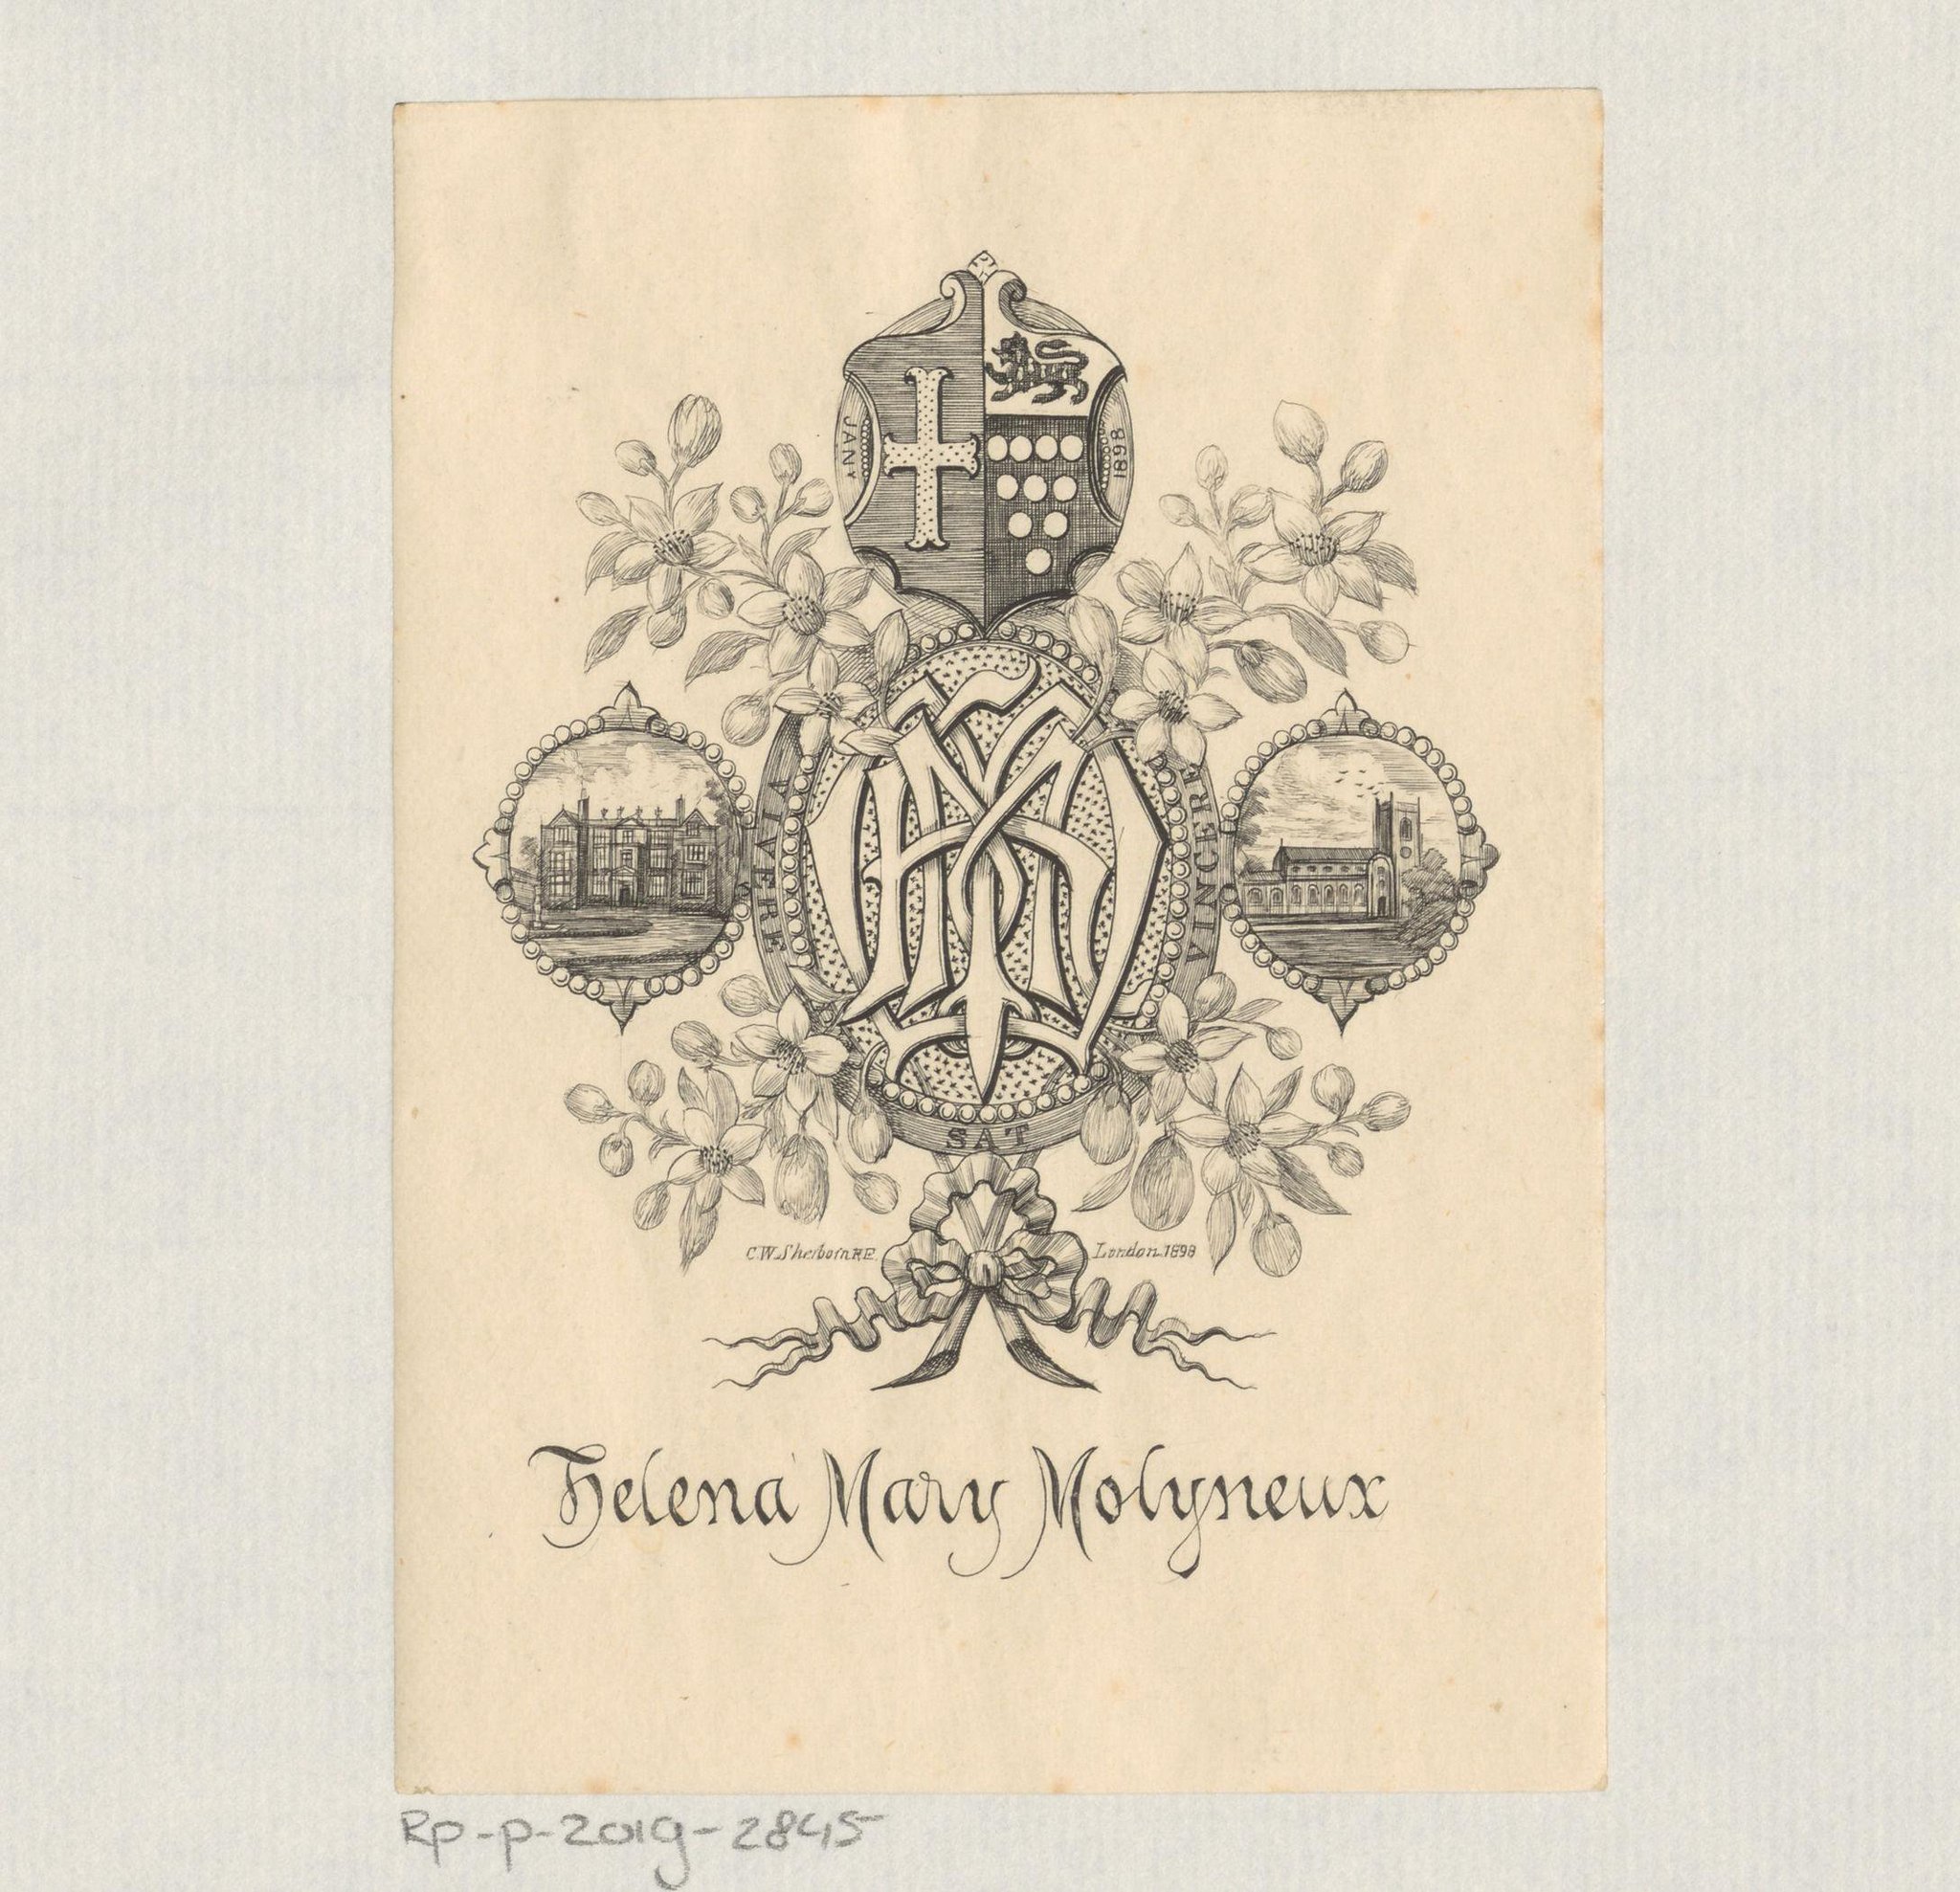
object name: bookplate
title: Ex libris van Helena Mary Molyneux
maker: charles william sherborn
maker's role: print maker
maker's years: 1831-1912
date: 1898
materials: paper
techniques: engraving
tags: initial, armorial bearing, heraldry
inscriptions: date